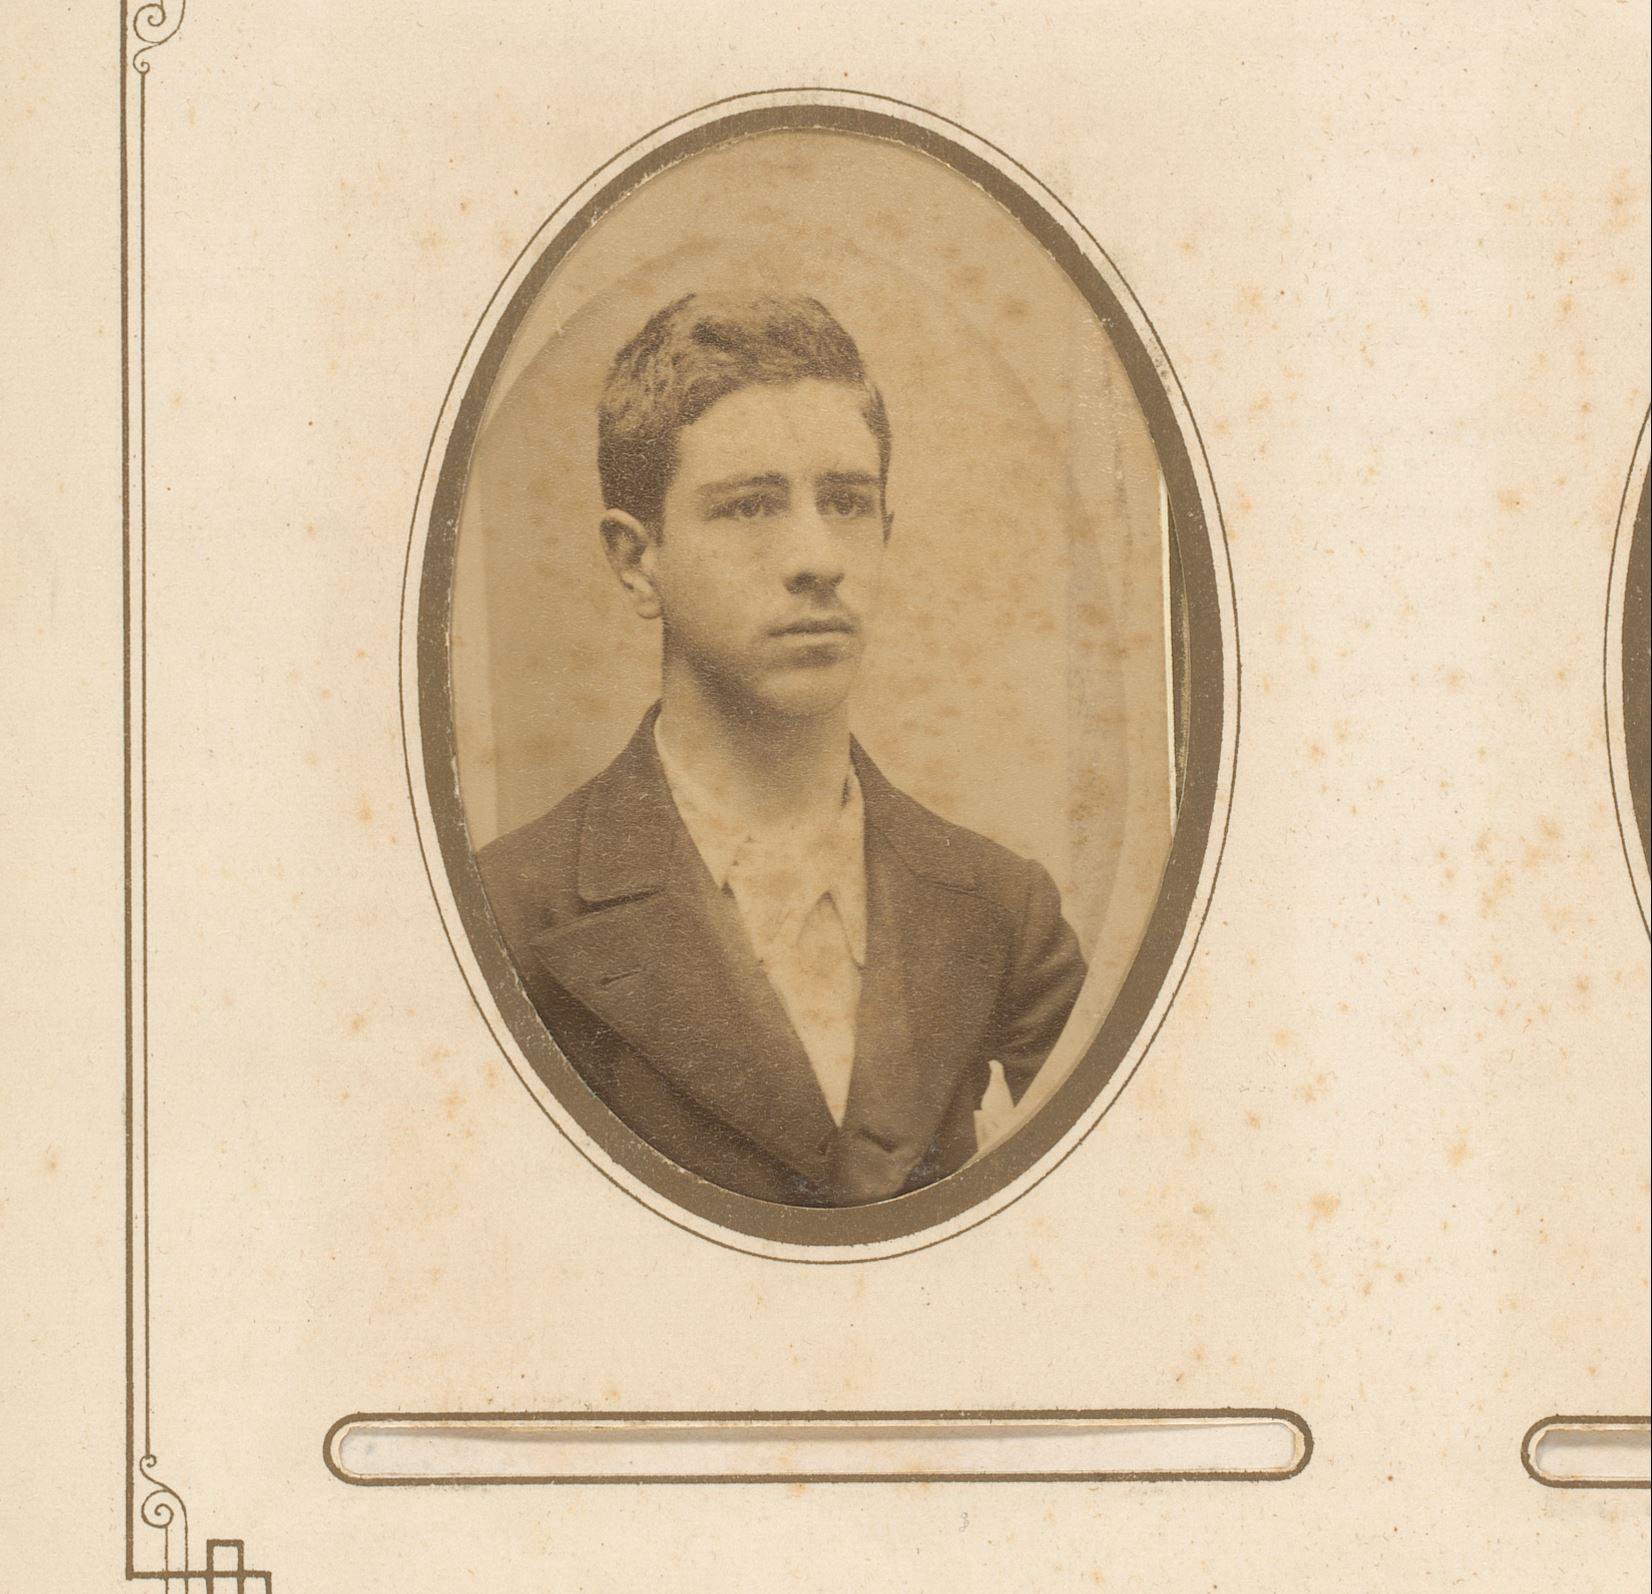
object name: photograph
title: Portret van een jongeman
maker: Anonymous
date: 1880-1920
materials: cardboard, photographic support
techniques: albumen print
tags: historical persons, youth, adolescent